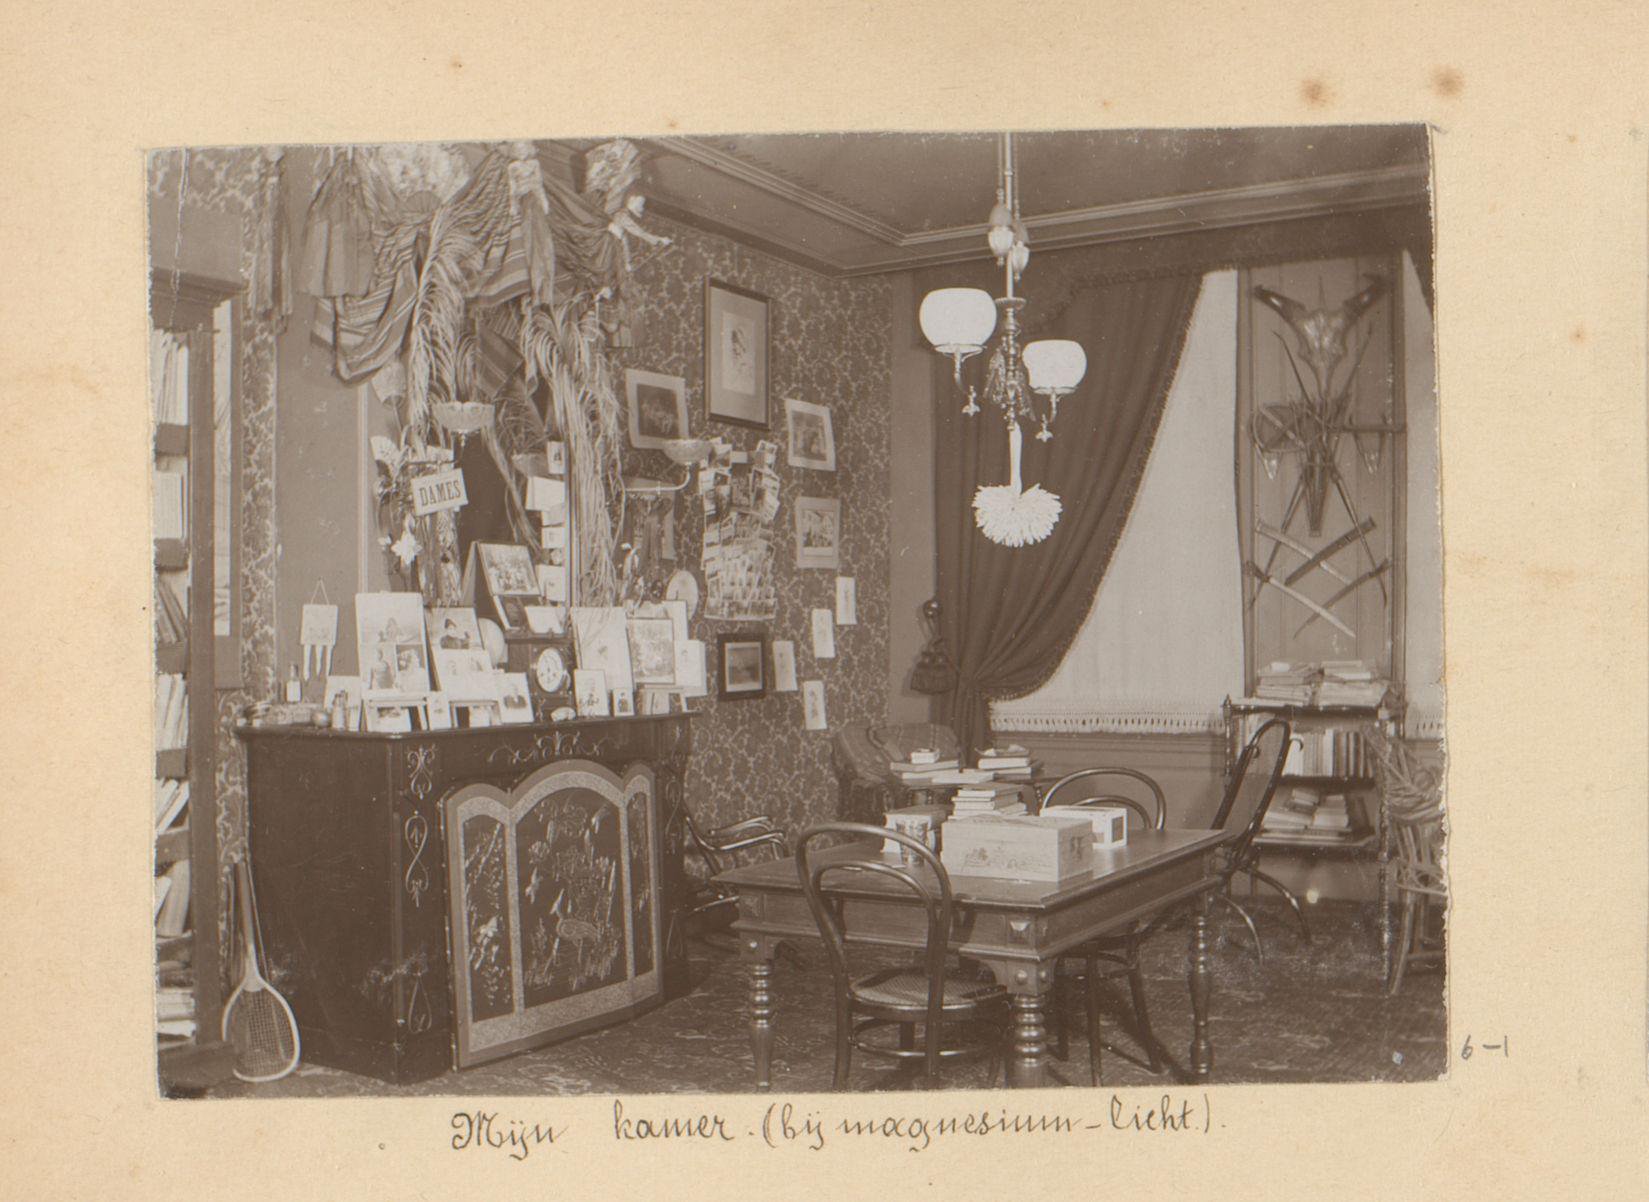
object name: photograph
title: Interieur van de kamer van Hendrik Herman van den Berg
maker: hendrik herman van den berg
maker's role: amateurfotograaf, jurist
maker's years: 1875-1944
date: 1890-1894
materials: paper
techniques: collodion silver print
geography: amsterdam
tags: interior ~ representation of a building, amsterdam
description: De foto is gemaakt bij flitslicht afkomstig van bliksempoeder.